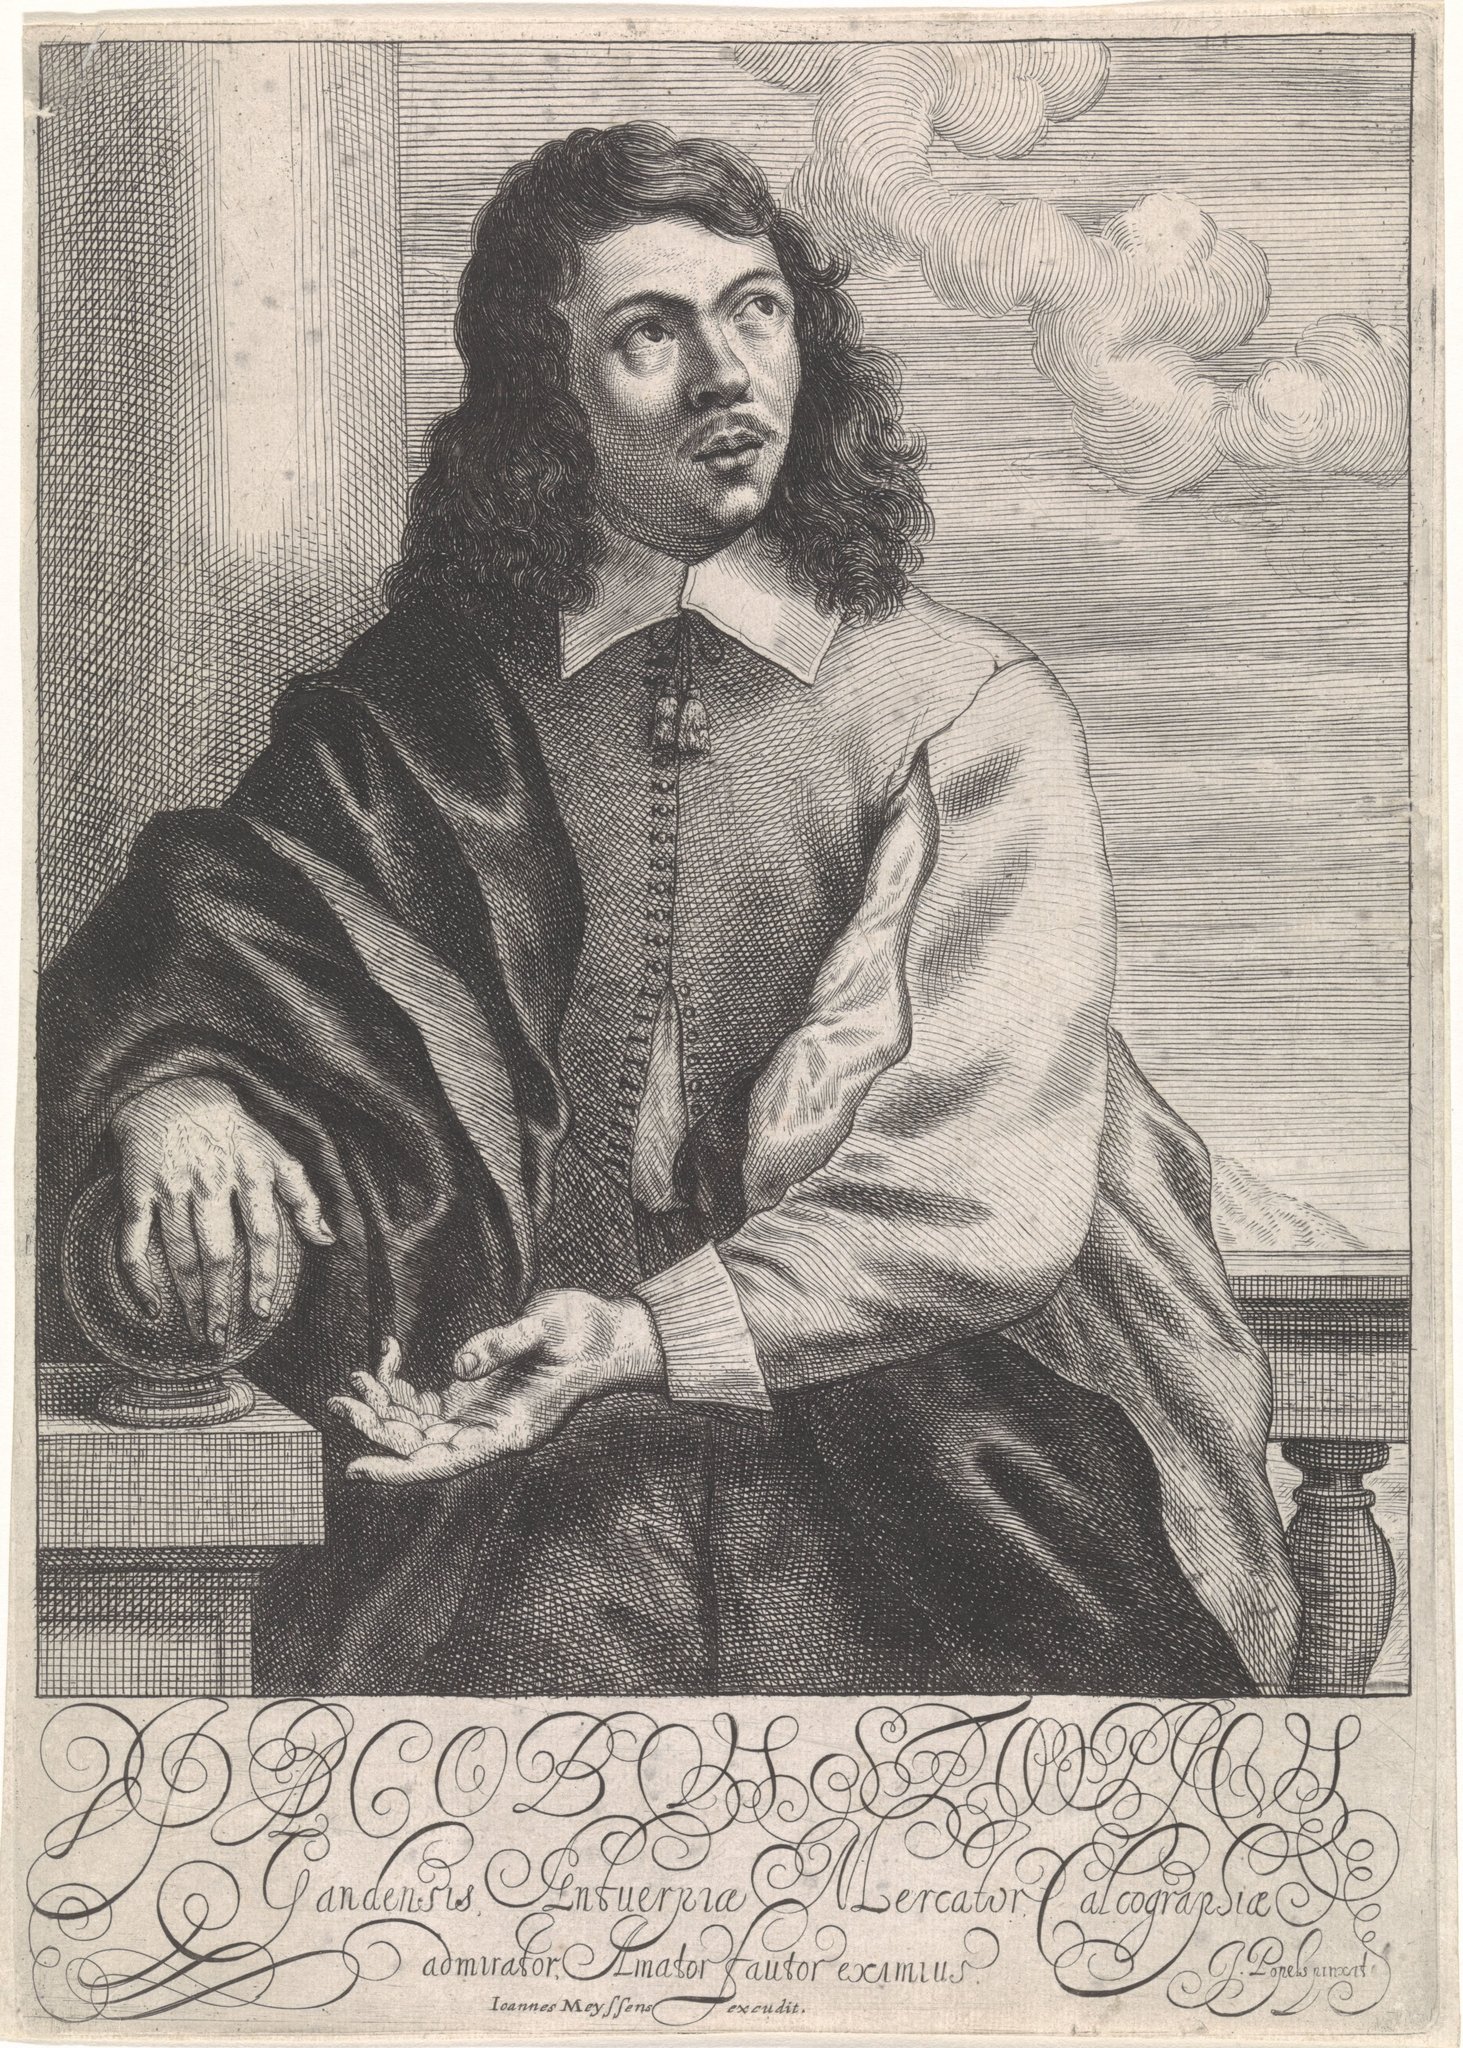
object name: print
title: Portret van Jacob Stoopius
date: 1630-1660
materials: paper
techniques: engraving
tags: portrait, self-portrait of painter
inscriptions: signature: ‘J. Popels Pinxit’, collector's mark: Lugt 2228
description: Portret ten halven lijve van de Antwerpse koopman en kalligraaf Jacob Stoopius, staand op een balustrade. Onder de afbeelding een tweeregelige Latijnse tekst.